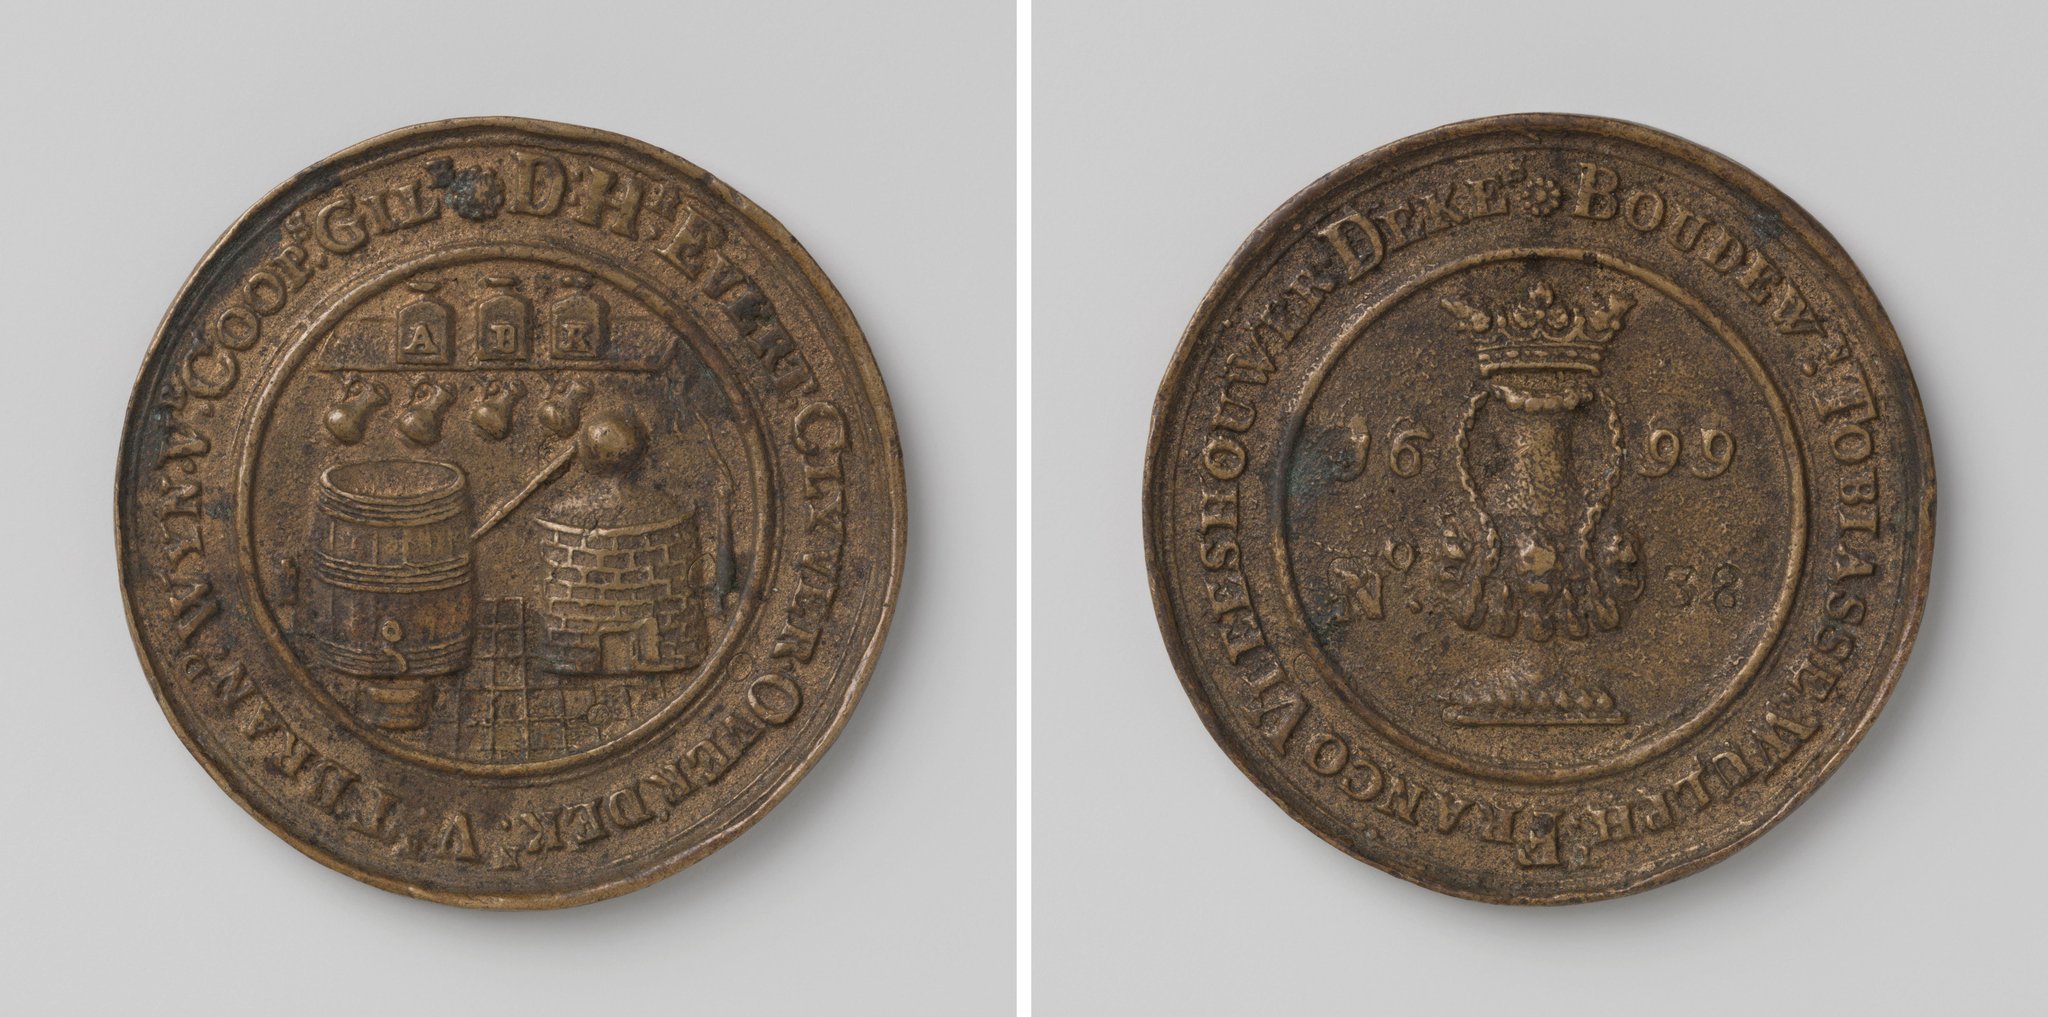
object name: medal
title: Brandewijnverkopersgilde van Vlissingen, gildepenning met no. 38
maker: Anonymous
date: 1699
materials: brass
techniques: casting, engraving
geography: flushing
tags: flushing